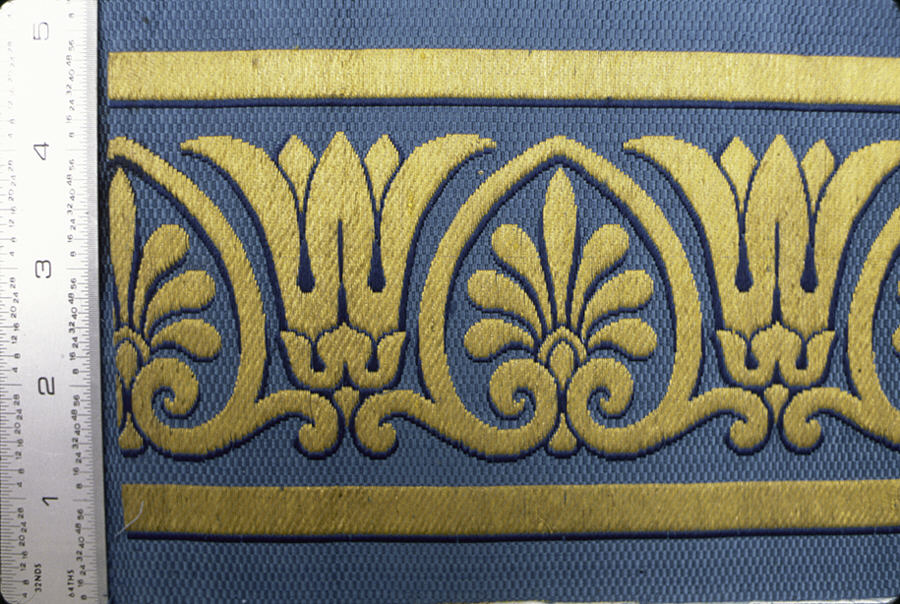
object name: border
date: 1801-1833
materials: metal thread, silk